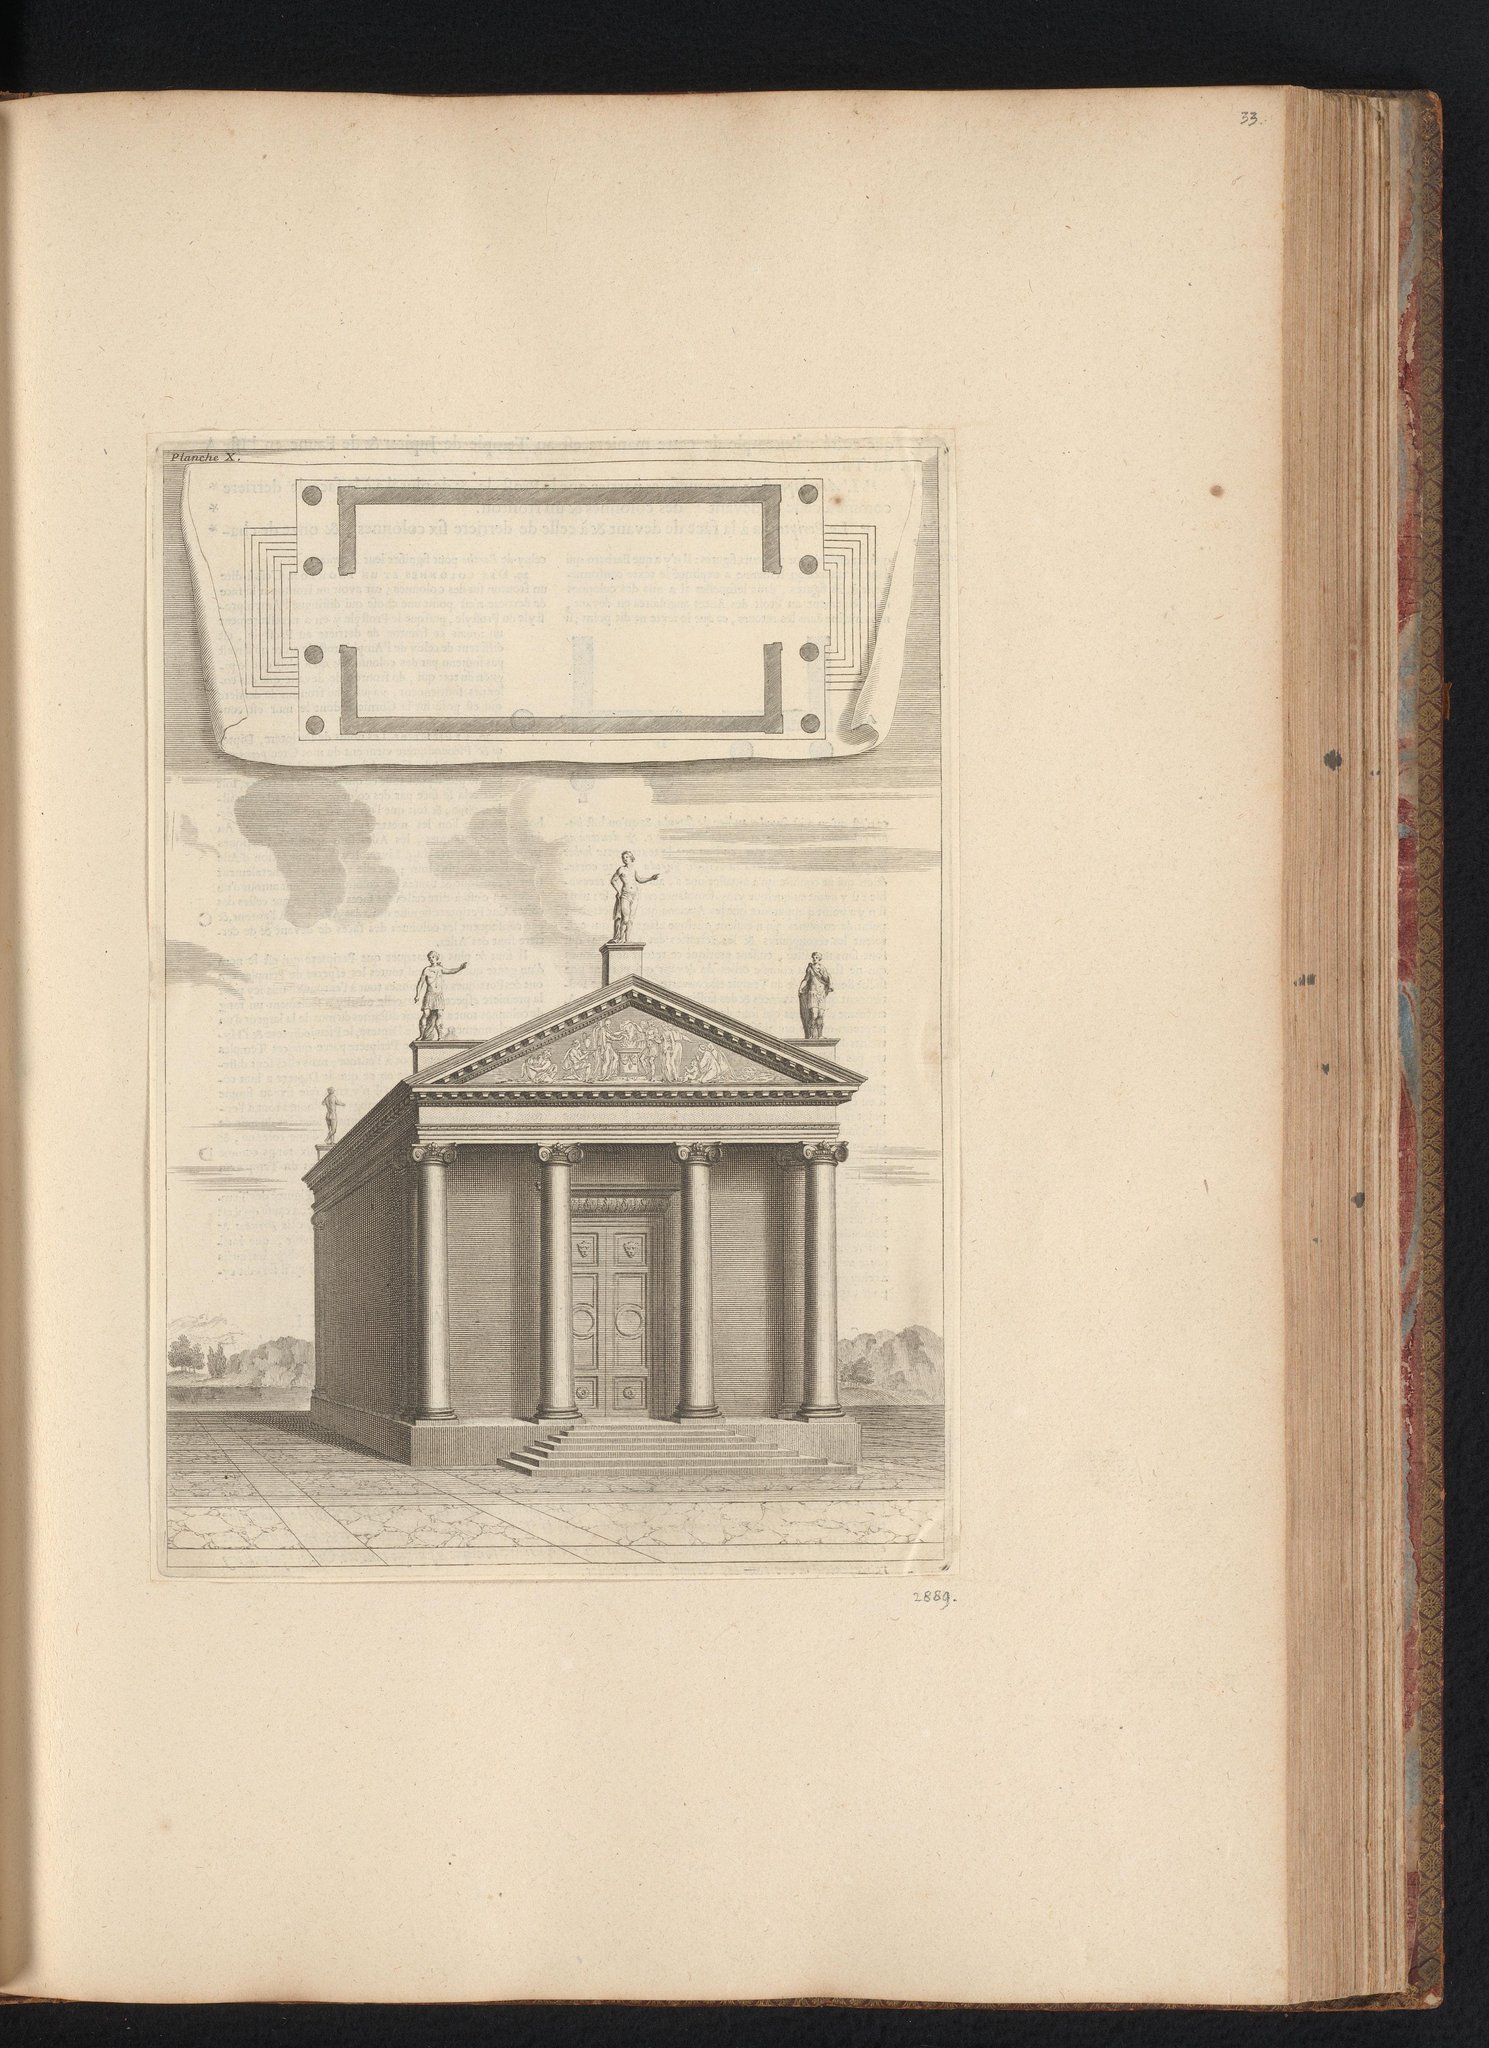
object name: album leaf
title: Gezicht op een tempel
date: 1673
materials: paper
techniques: engraving, etching, letterpress printing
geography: paris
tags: temple, shrine ~ roman religion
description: Plattegrond en voor- en linkerzijde van een tempel. De tempel is een amphiprostylos met Ionische zuilen. Prent maakt deel uit van een album.